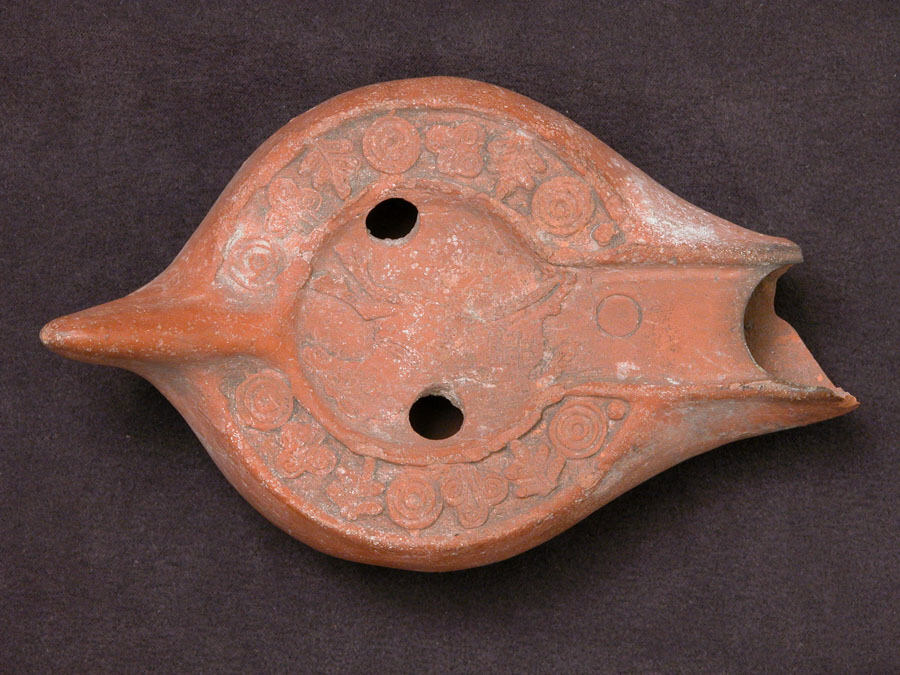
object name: lamp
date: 401-600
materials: earthenware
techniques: molding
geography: egypt